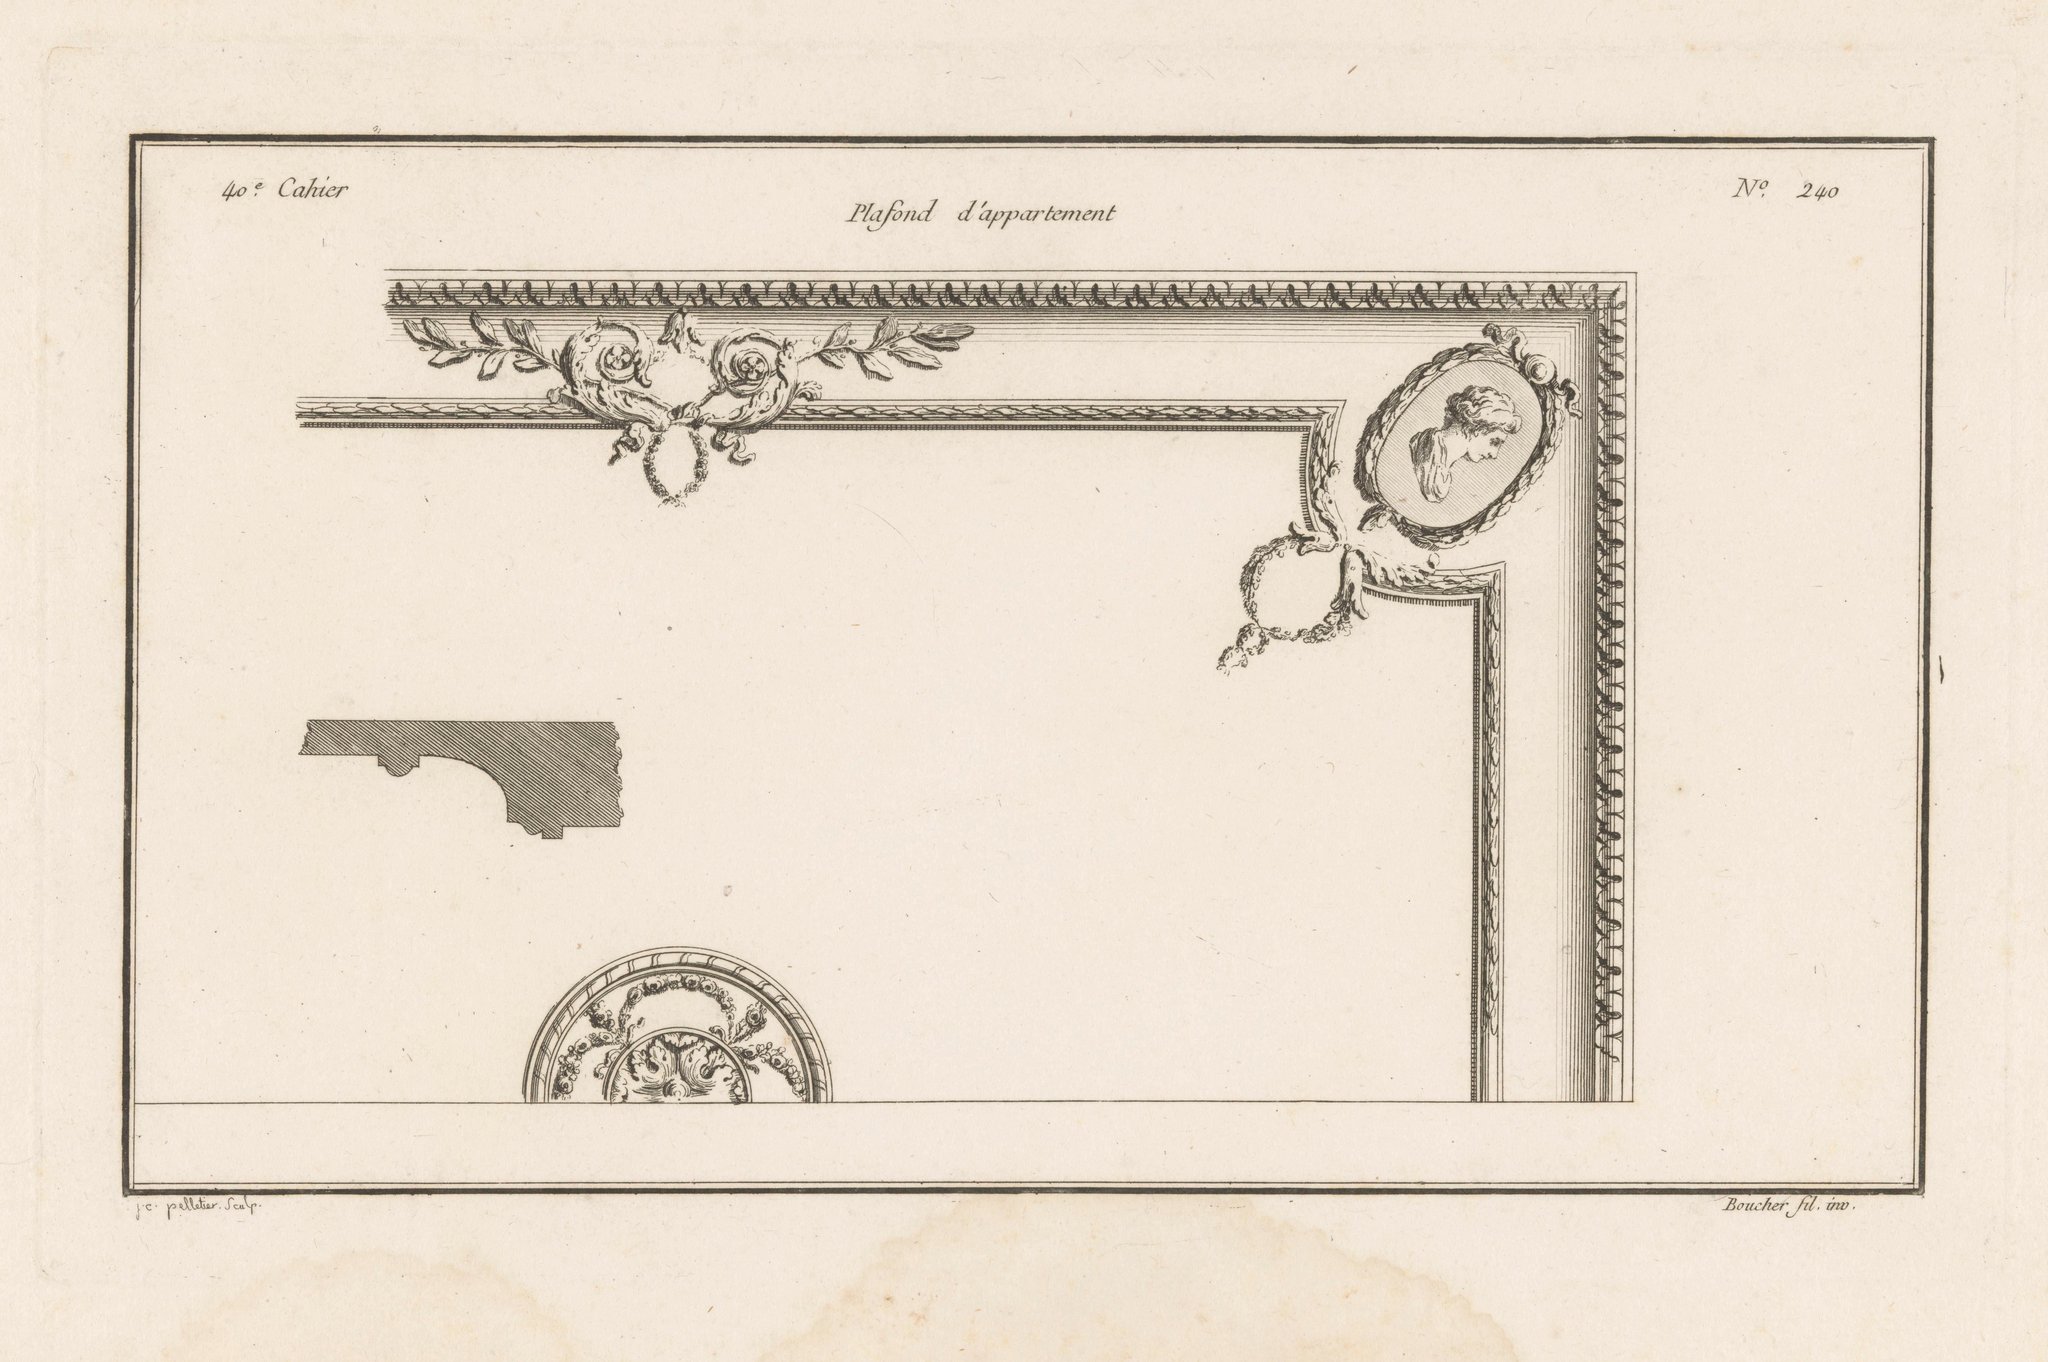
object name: print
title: Plafond met vlechtwerk en medaillons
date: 1772-1779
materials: paper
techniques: engraving, etching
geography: paris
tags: interlace ~ ornament, ornament ~ medallion, (decorated) ceiling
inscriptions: collector's mark: Lugt 2760, collector's mark: Lugt 2228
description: Profiel en detail van een geornamenteerd plafond met vlechtwerk, een vrouwenportret en profil in een medaillon en in het midden een rond element. Prentnummer 240.